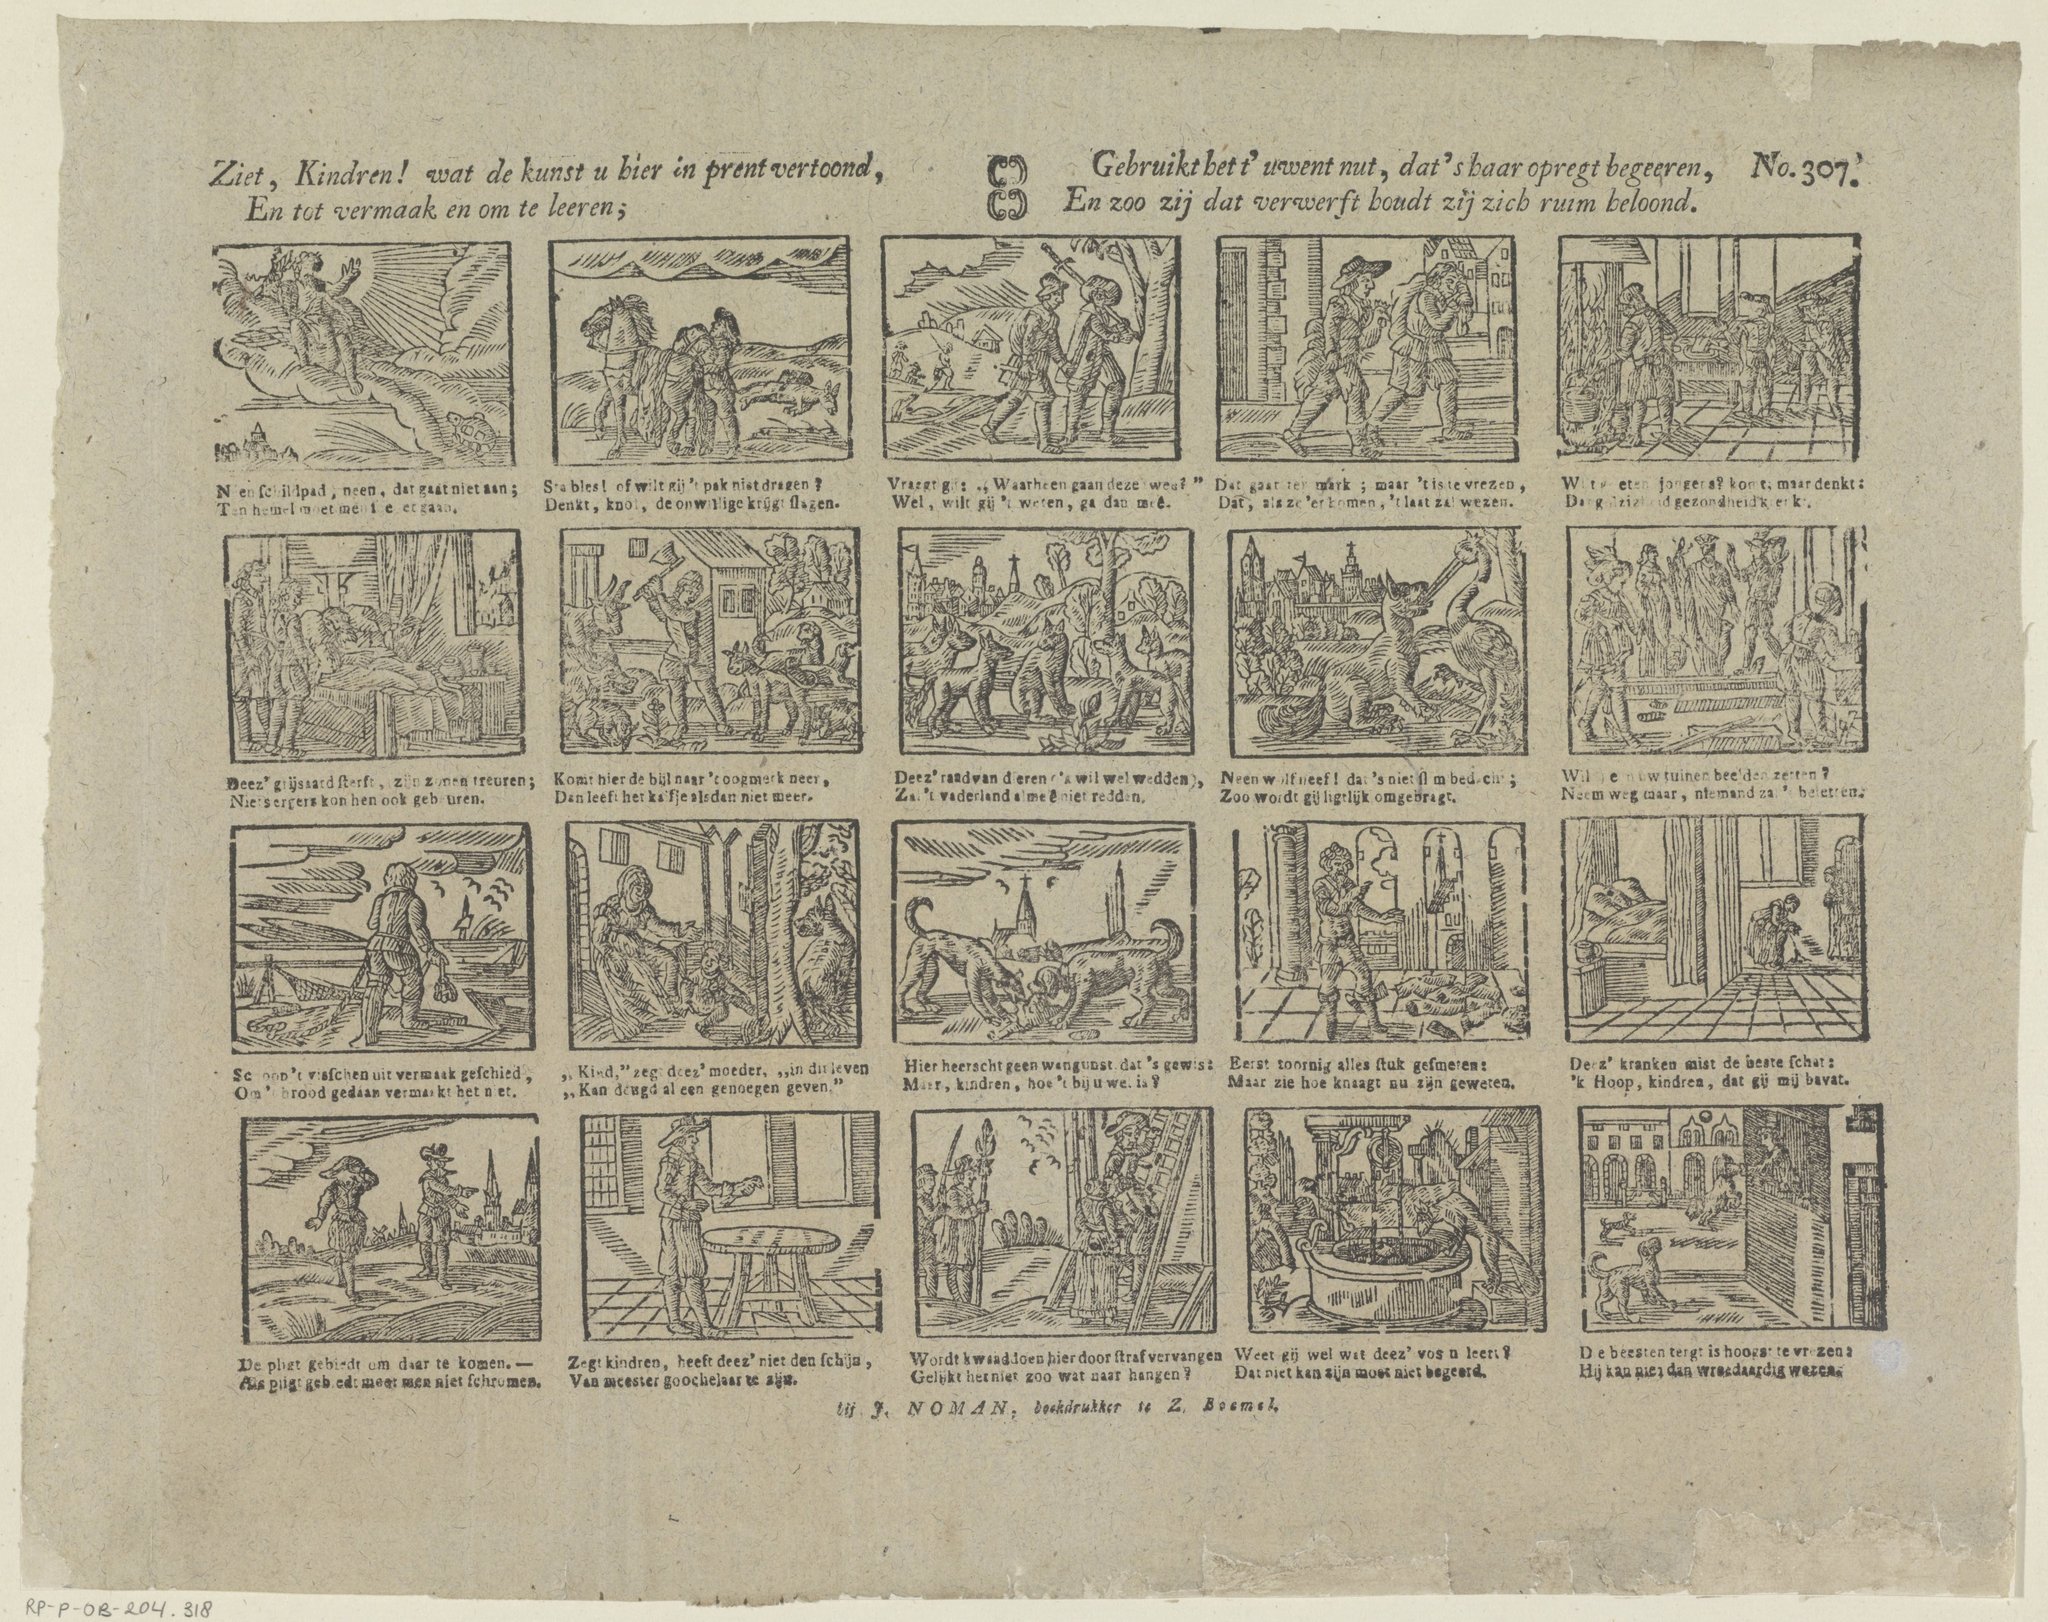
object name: popular print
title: Ziet, kindren! wat de kunst u hier in prent vertoond, / En tot vermaak en om te leeren; / Gebruikt het 't uwent nut, dat's haar opregt begeeren, / En zoo zij dat verwerft houdt zij zich ruim beloond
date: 1806-1830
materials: paper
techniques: letterpress printing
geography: netherlands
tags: animals, fables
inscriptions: collector's mark: Lugt 2760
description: Blad met 20 voorstellingen uit de fabelen van Aesopus. Onder elke afbeelding een tweeregelig vers. Genummerd rechtsboven: No. 307.